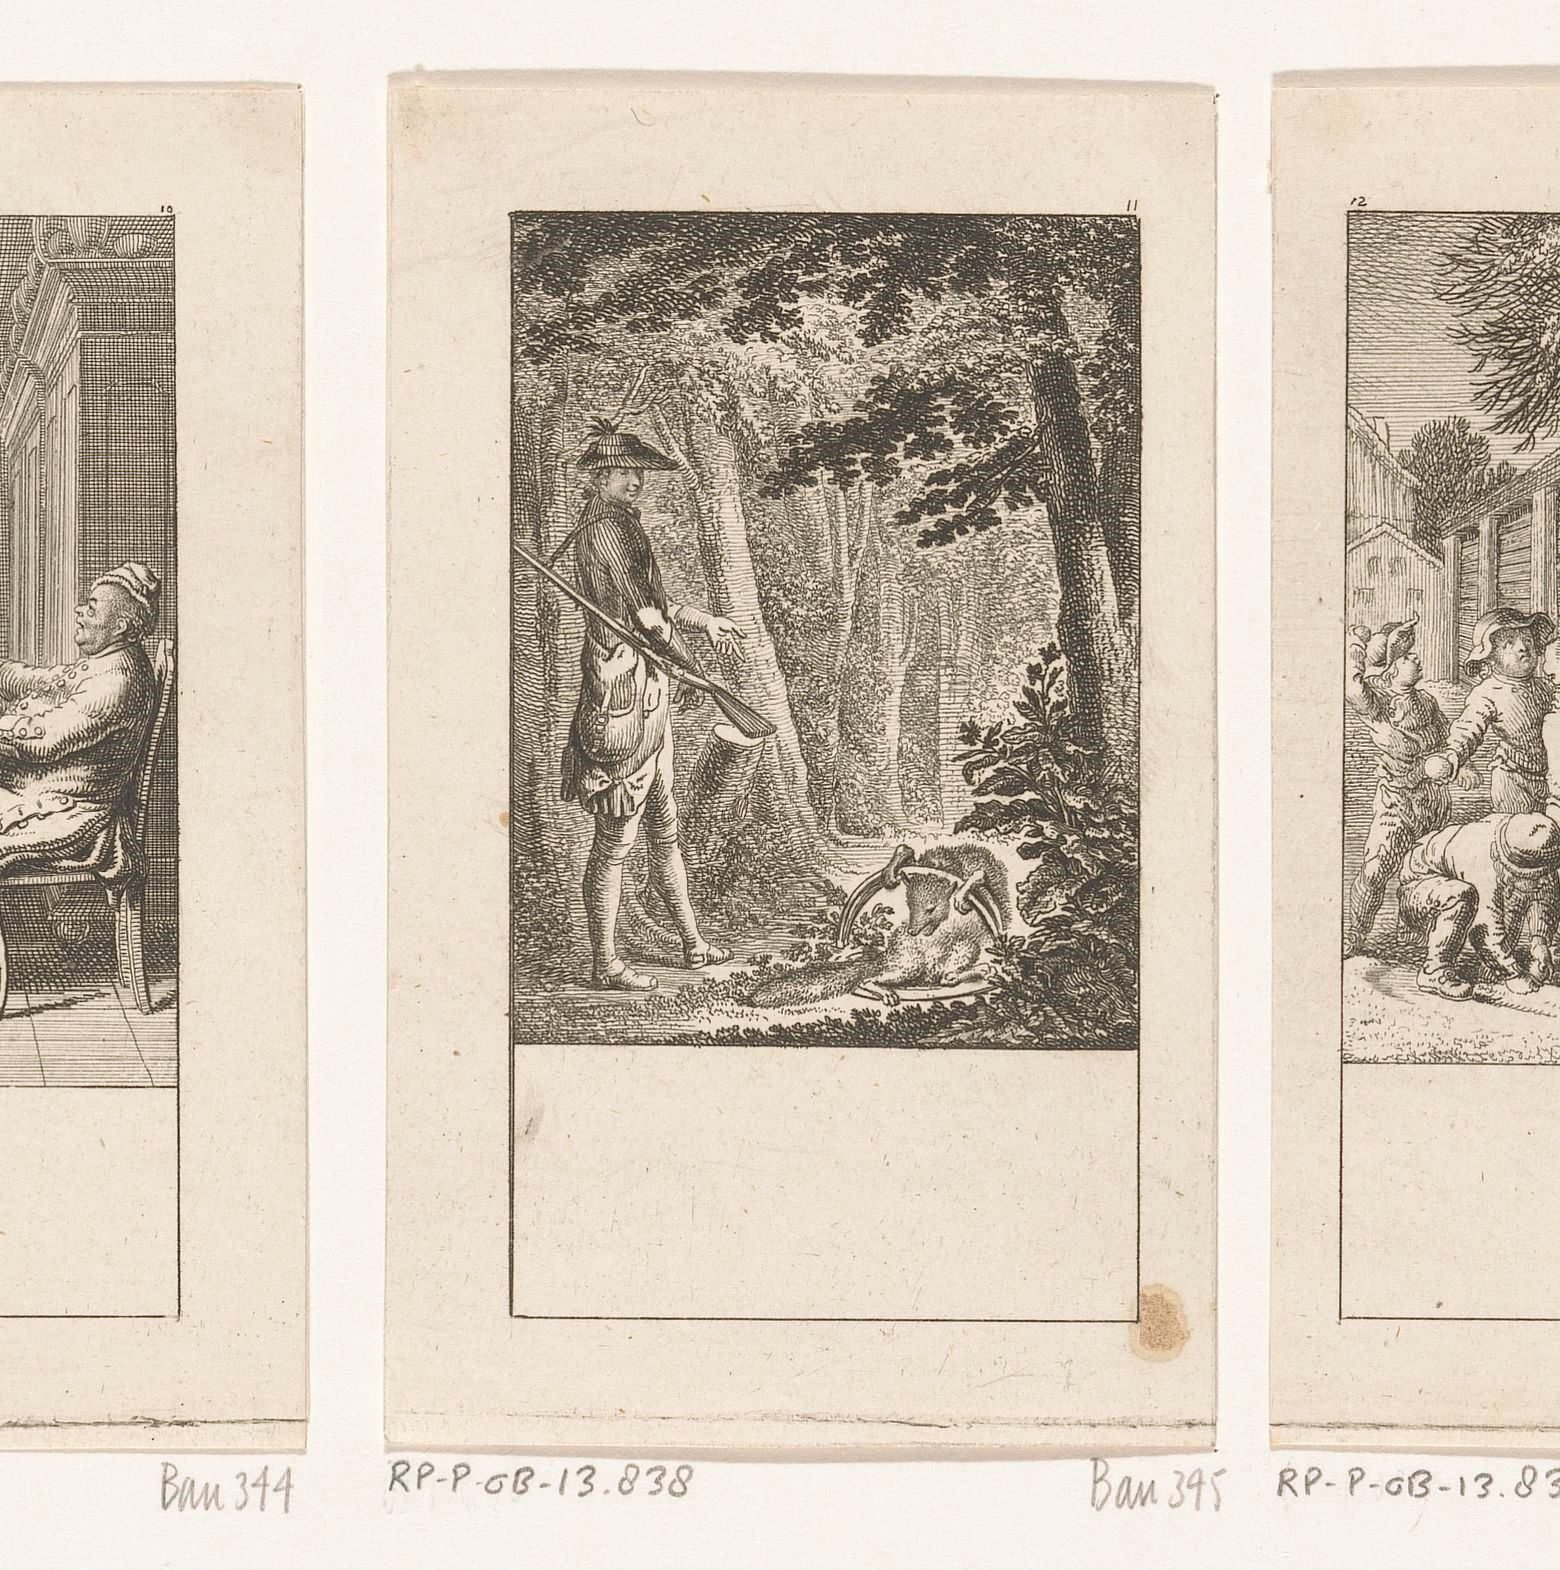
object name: print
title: November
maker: daniel nikolaus chodowiecki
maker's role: draughtsman, print maker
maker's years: 1726-1801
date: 1777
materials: paper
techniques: etching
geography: berlin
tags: november and its 'labours', fox hunting, forest, wood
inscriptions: collector's mark: Lugt 2228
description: Afkomstig uit een serie met de twaalf maanden. Deze serie werd op een plaat geëtst. Een latere staat van deze serie werd gebruikt in: Königl. Großbrit. Churf. Braunschw. Lüneb. Genealogischen Kalender, auf das Jahr 1778. Lauenburg: Johann Georg Berenberg.